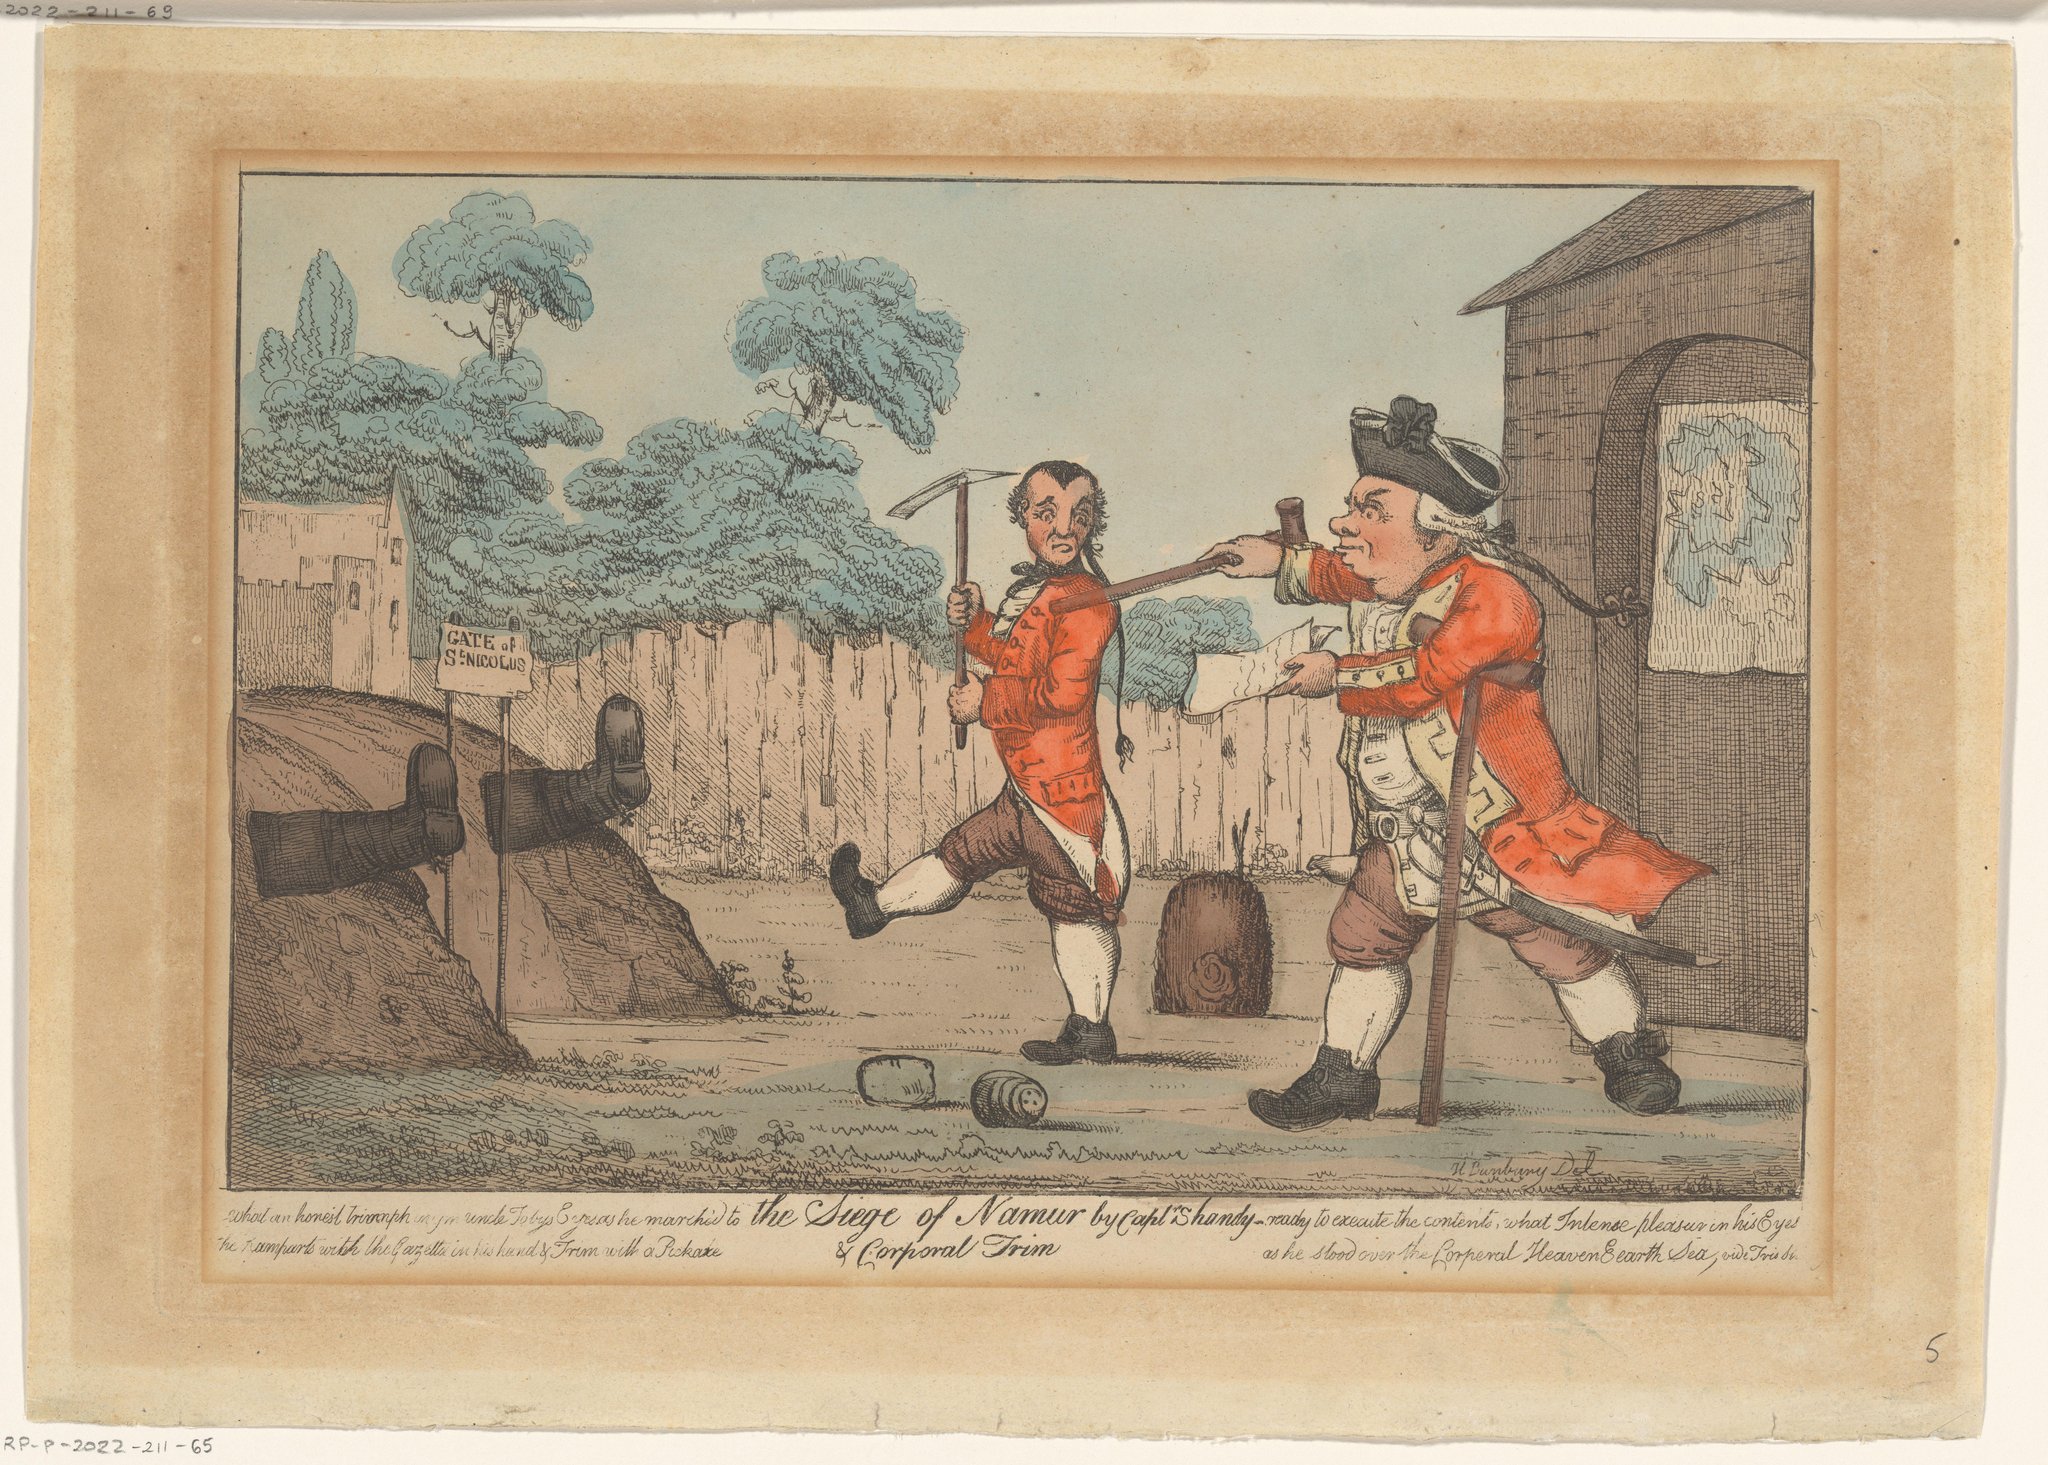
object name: book illustration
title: De belegering van Namur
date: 1759-1767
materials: paper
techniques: etching, hand coloring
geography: europe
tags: caricatures (human types), (scenes from) specific works of literature (with author, title), military training, siege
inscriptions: collector's mark: Lugt 2228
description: Oom Toby (rechts) marcheert van rechts naar links, een kruk onder zijn linkerarm, en wijst met zijn rechterkruk in de richting van de vestingwerken (links), waar de 'Gate of St Nicolas' aan elke kant wordt geflankeerd door een laars. In zijn linkerhand houdt hij de 'London Gazette'. Trim, die een houweel omhoog houdt, marcheert voor zijn meester uit. Een illustratie voor Laurence Sterne’s The Life and Opinions of Tristram Shandy, Gentleman (York 1759- 1767).